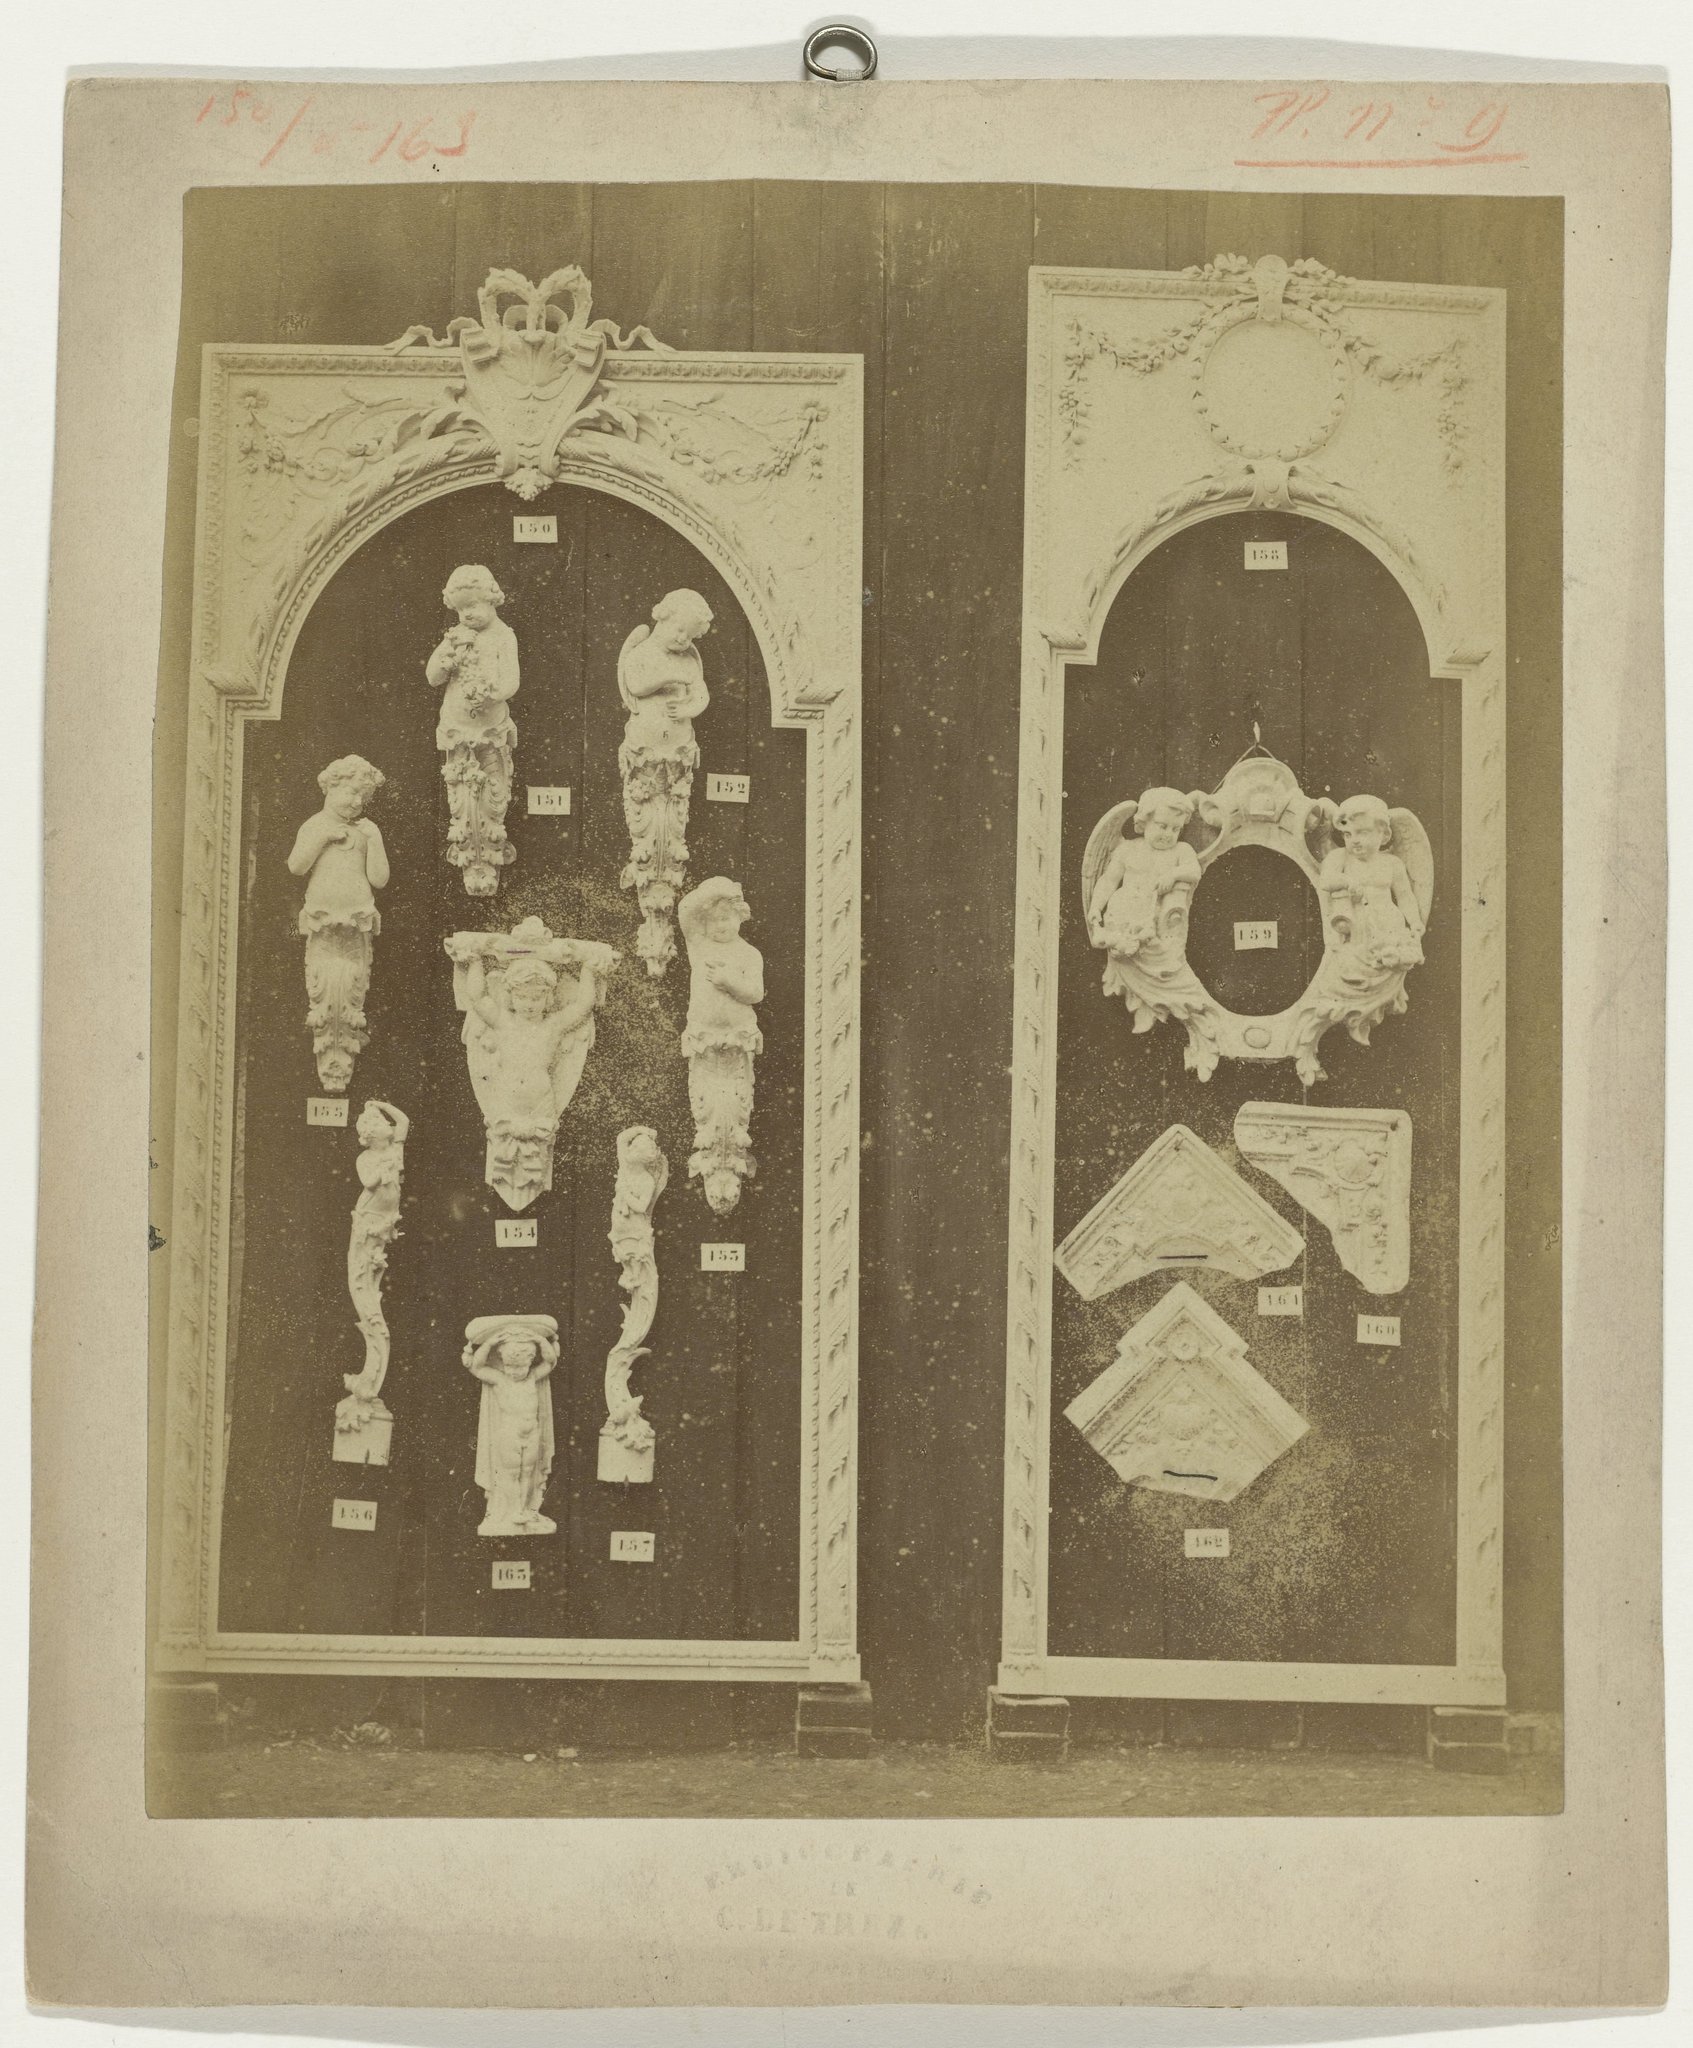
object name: photograph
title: Compositie van gipsen ornamenten uit het atelier van J. Delbove, Brussel, België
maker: charles de trez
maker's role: painter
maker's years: 1822-1899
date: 1860-1882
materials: cardboard, paper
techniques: albumen print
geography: brussels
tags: piece of sculpture, reproduction of a piece of sculpture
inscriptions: inscription: ‘Planche No. 9’, check stamp: ‘PHOTOGRAPHIE/ DE/ C. DE TREZ &/ RUE DU PONT NEUF 1’, inscription: ‘150 à 163 PP. No. 9’, check stamp: ‘J.H DELBOVE/ Rue de Malines, 37/ BRUXELLES’, number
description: Foto uit een incomplete serie van 13 foto's. Foto heeft sporen van een oogje aan de bovenzijde waaruit blijkt dat de foto gehangen heeft. Recto zijn nummers per voorwerp meegefotografeerd, corresponderend met een handgeschreven lijst die verso is geplakt.